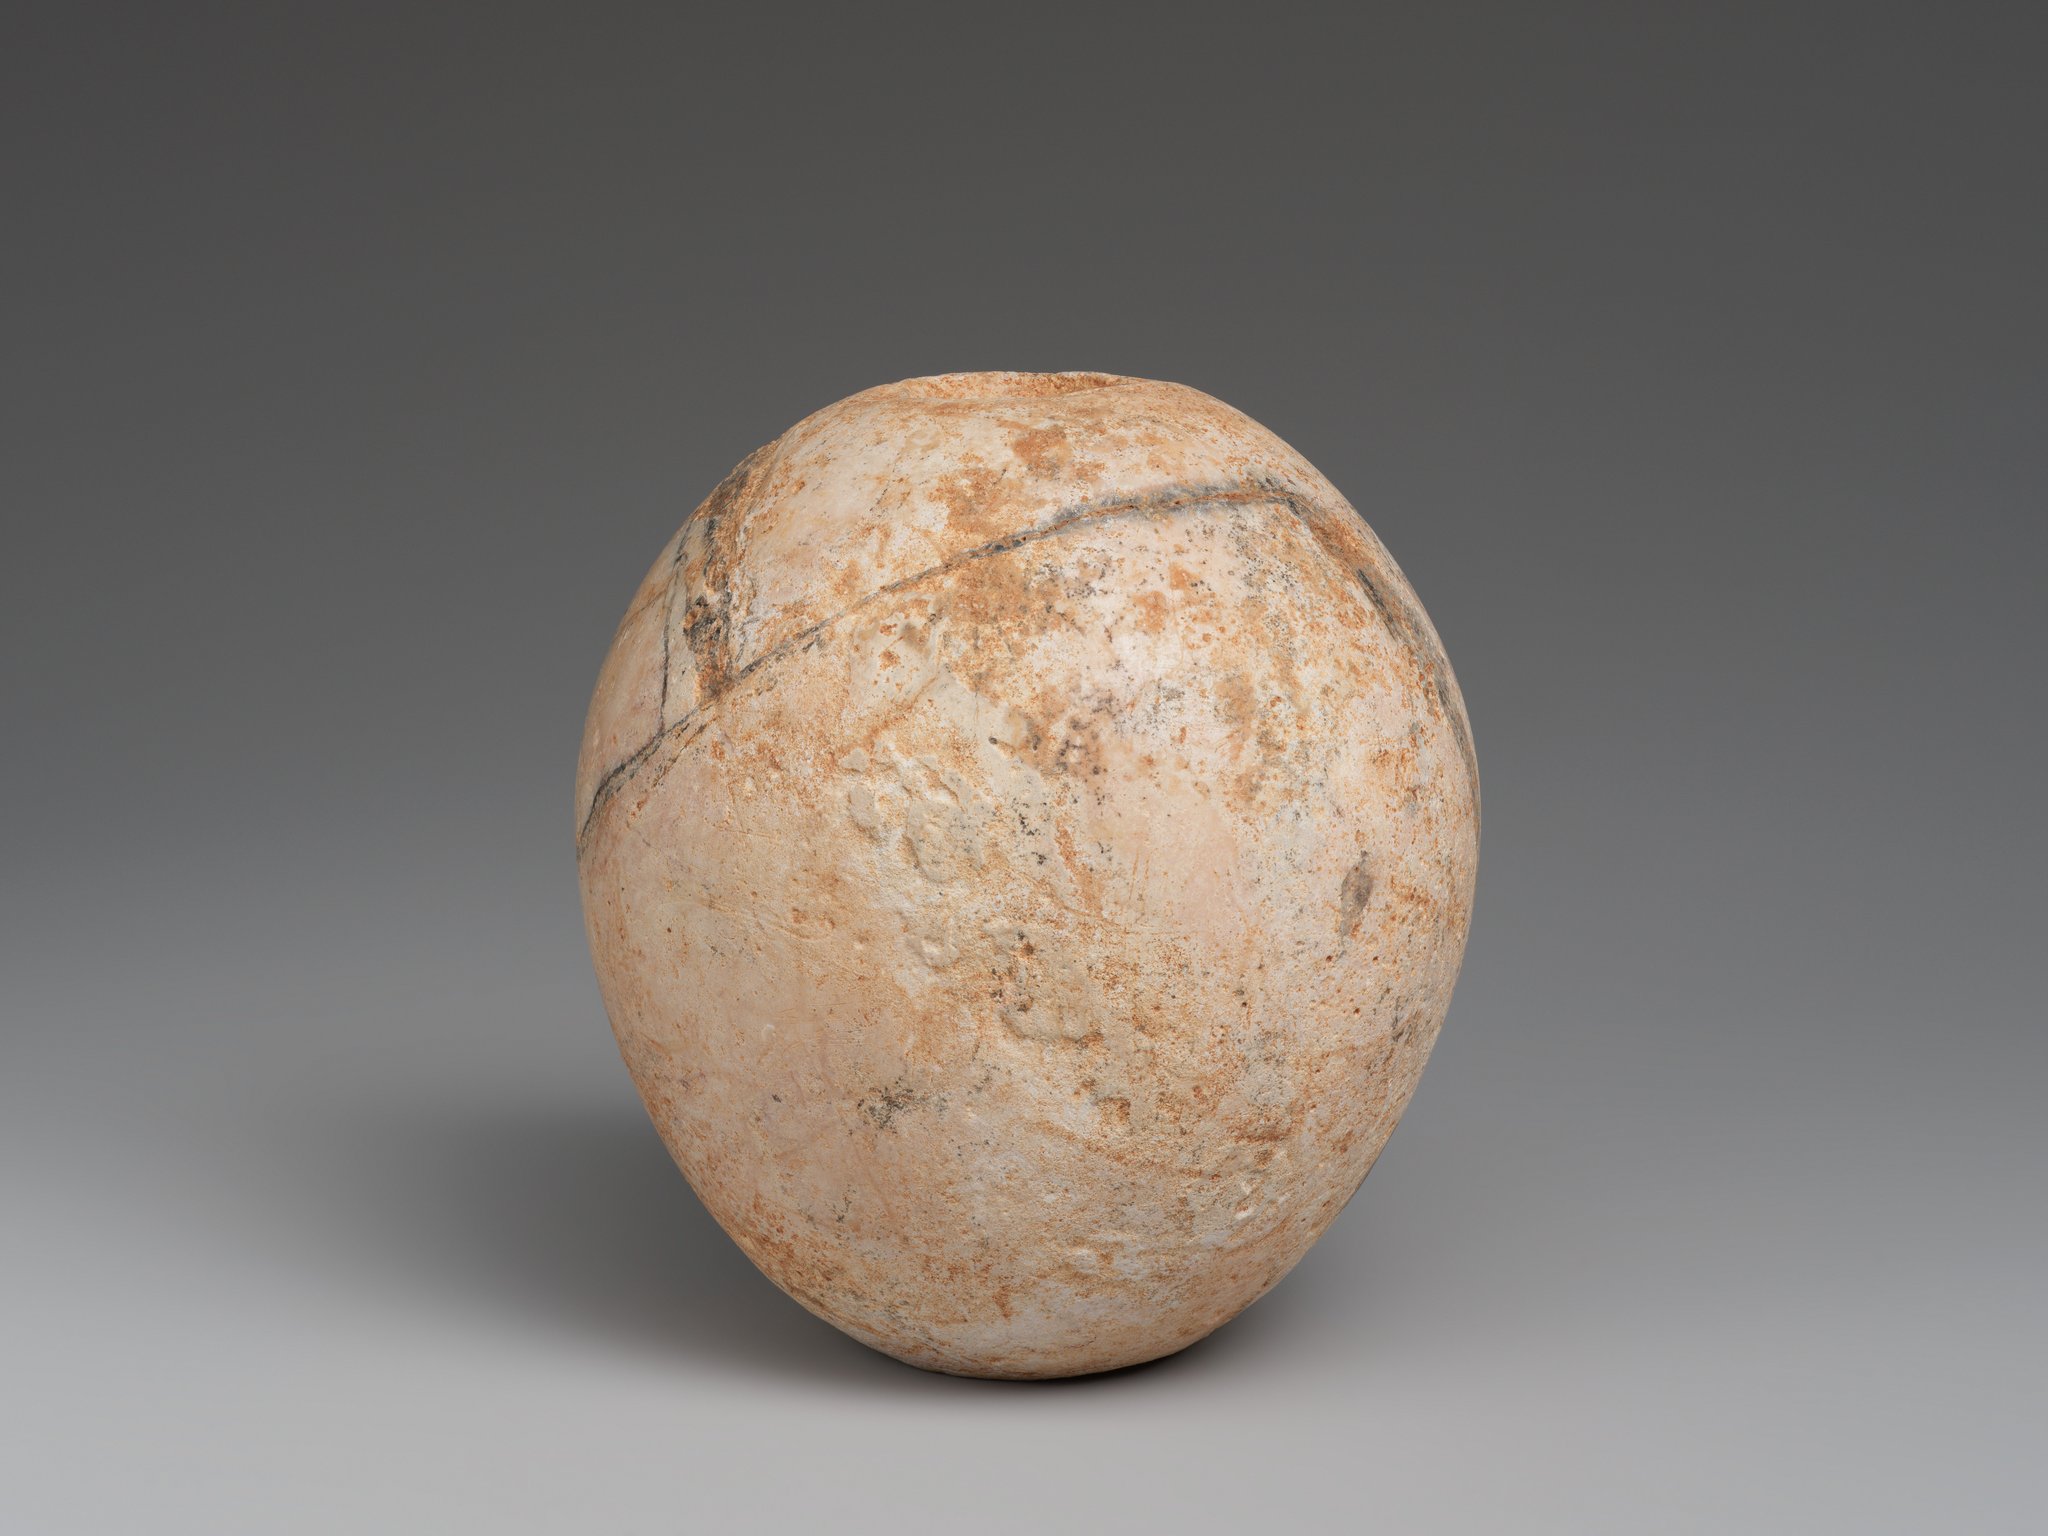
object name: mace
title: Mace head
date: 7000-5001 BCE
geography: syria